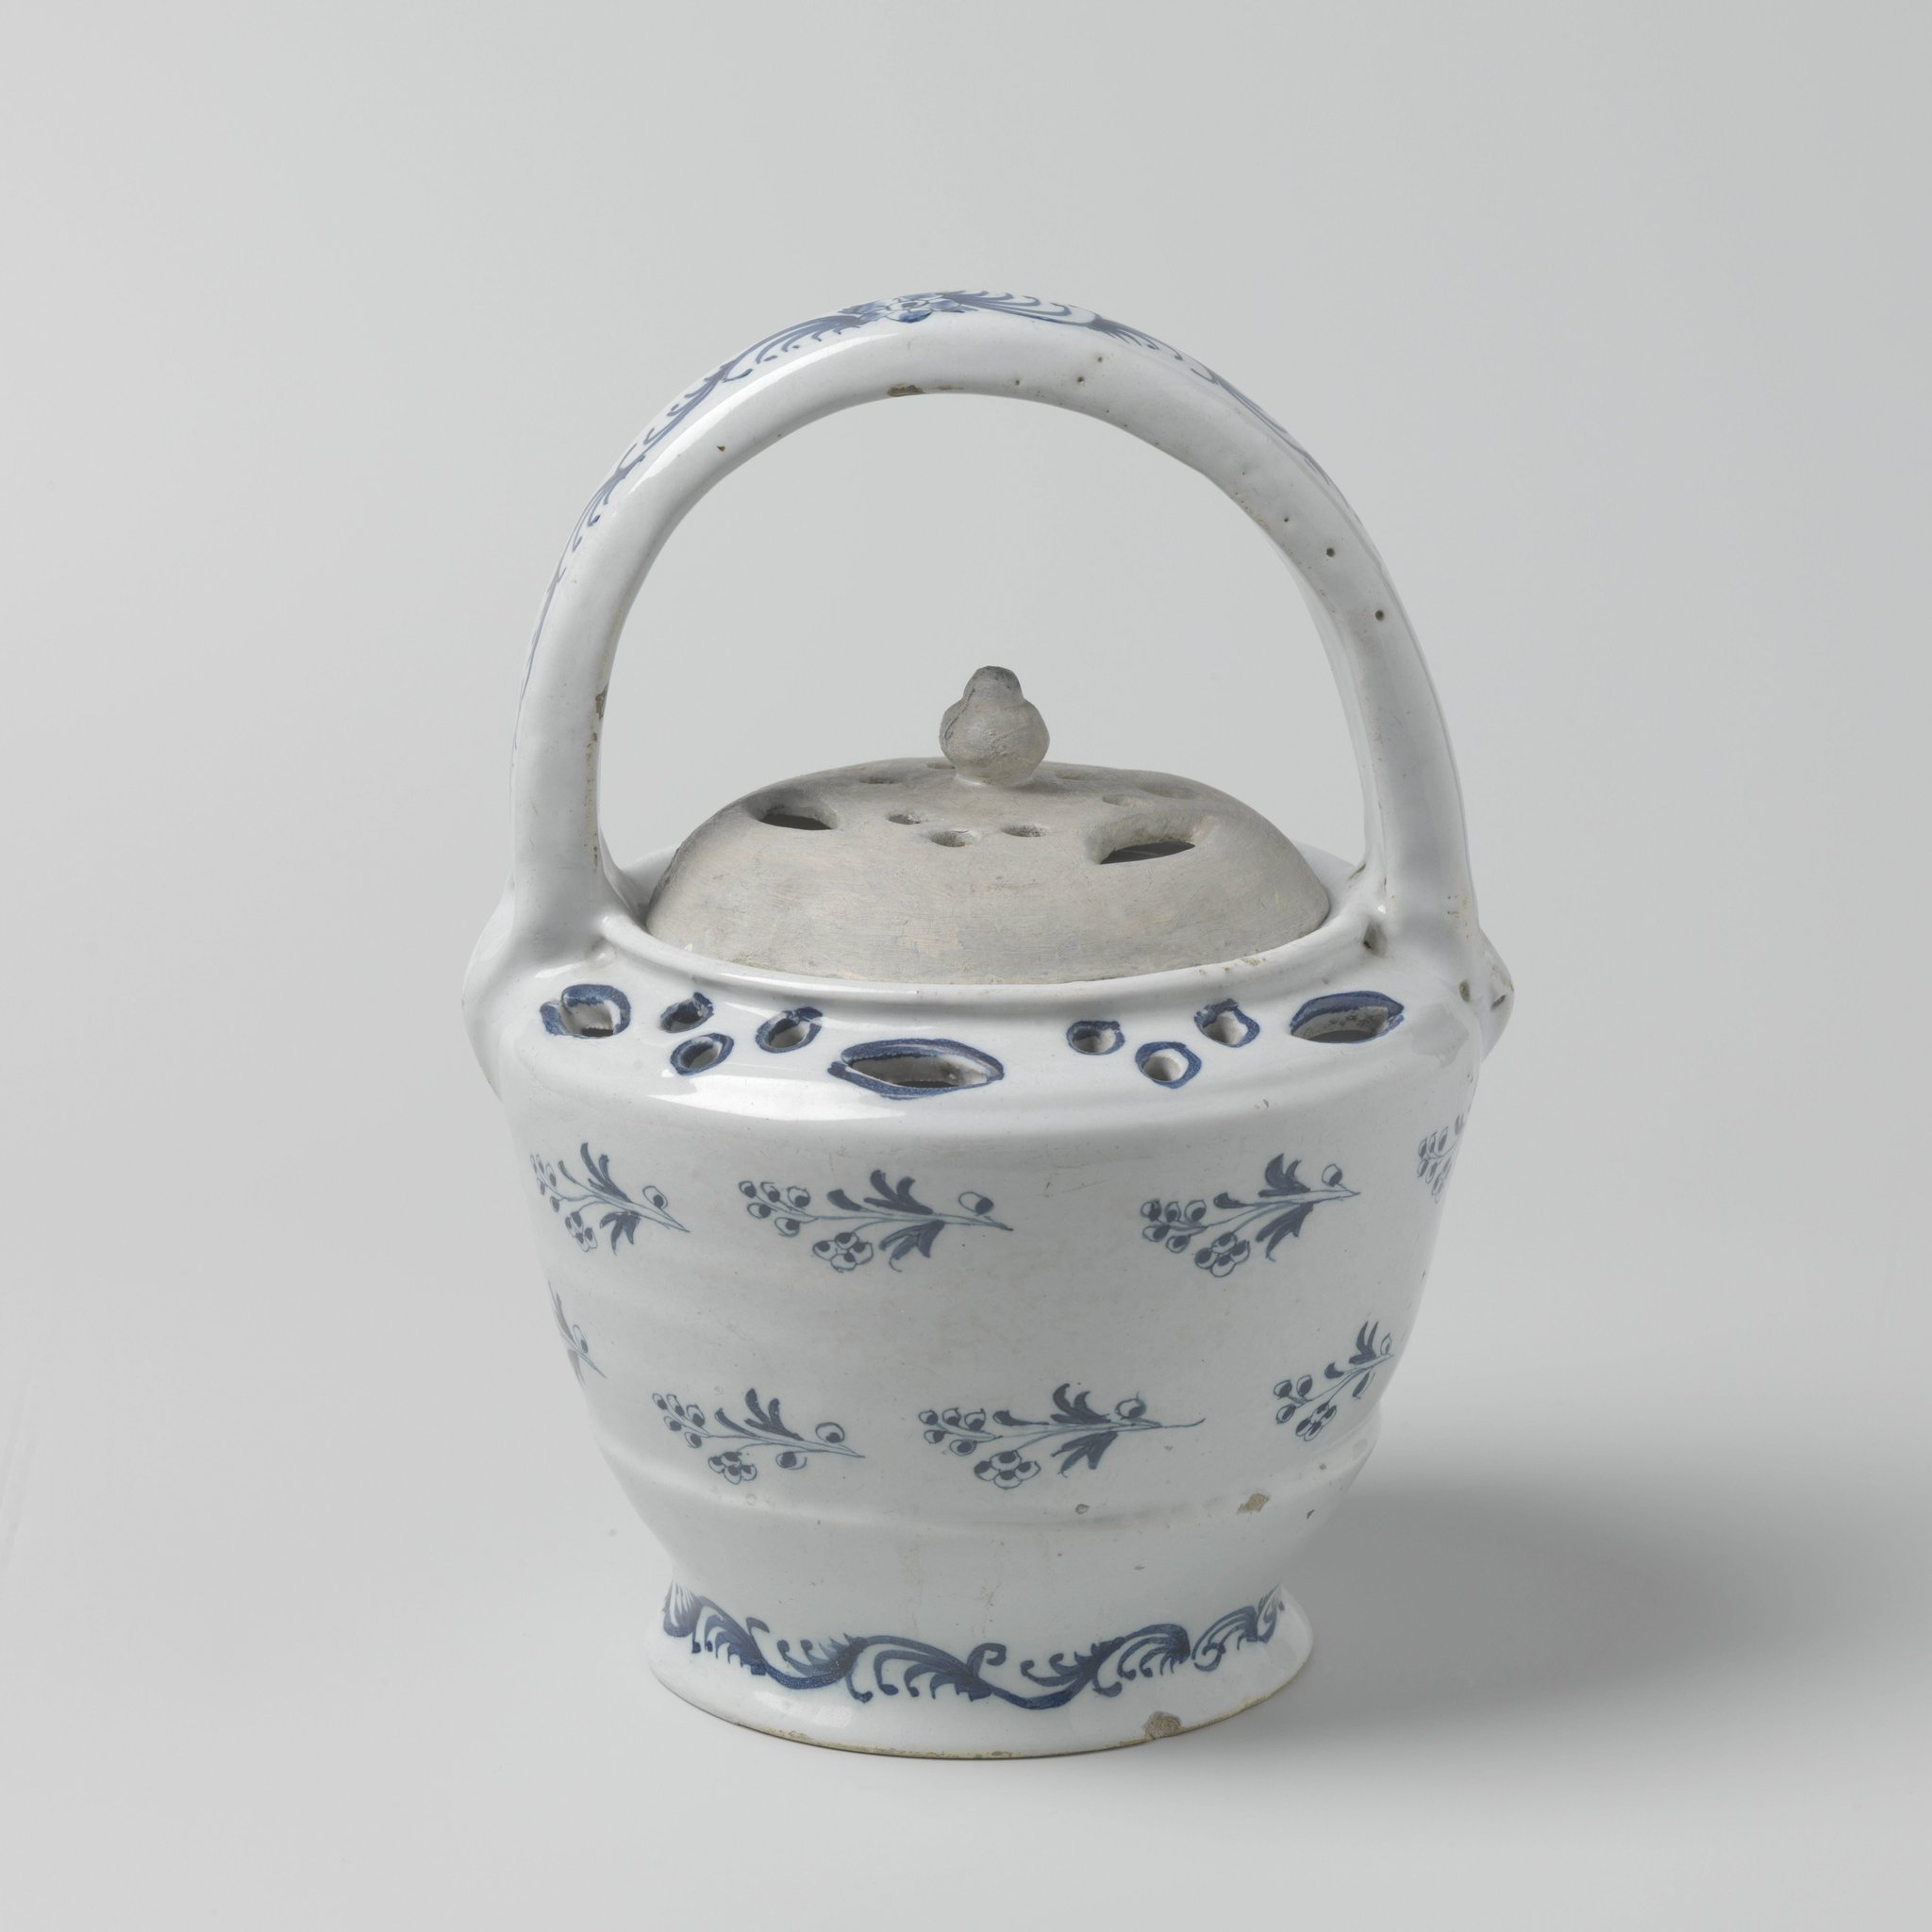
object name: tureen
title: Terrine, bestrooid met strooibloemen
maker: Anonymous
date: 1775-1820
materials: faience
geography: brussels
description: Terrine van faience. Blauw beschilderd met strooibloemen.